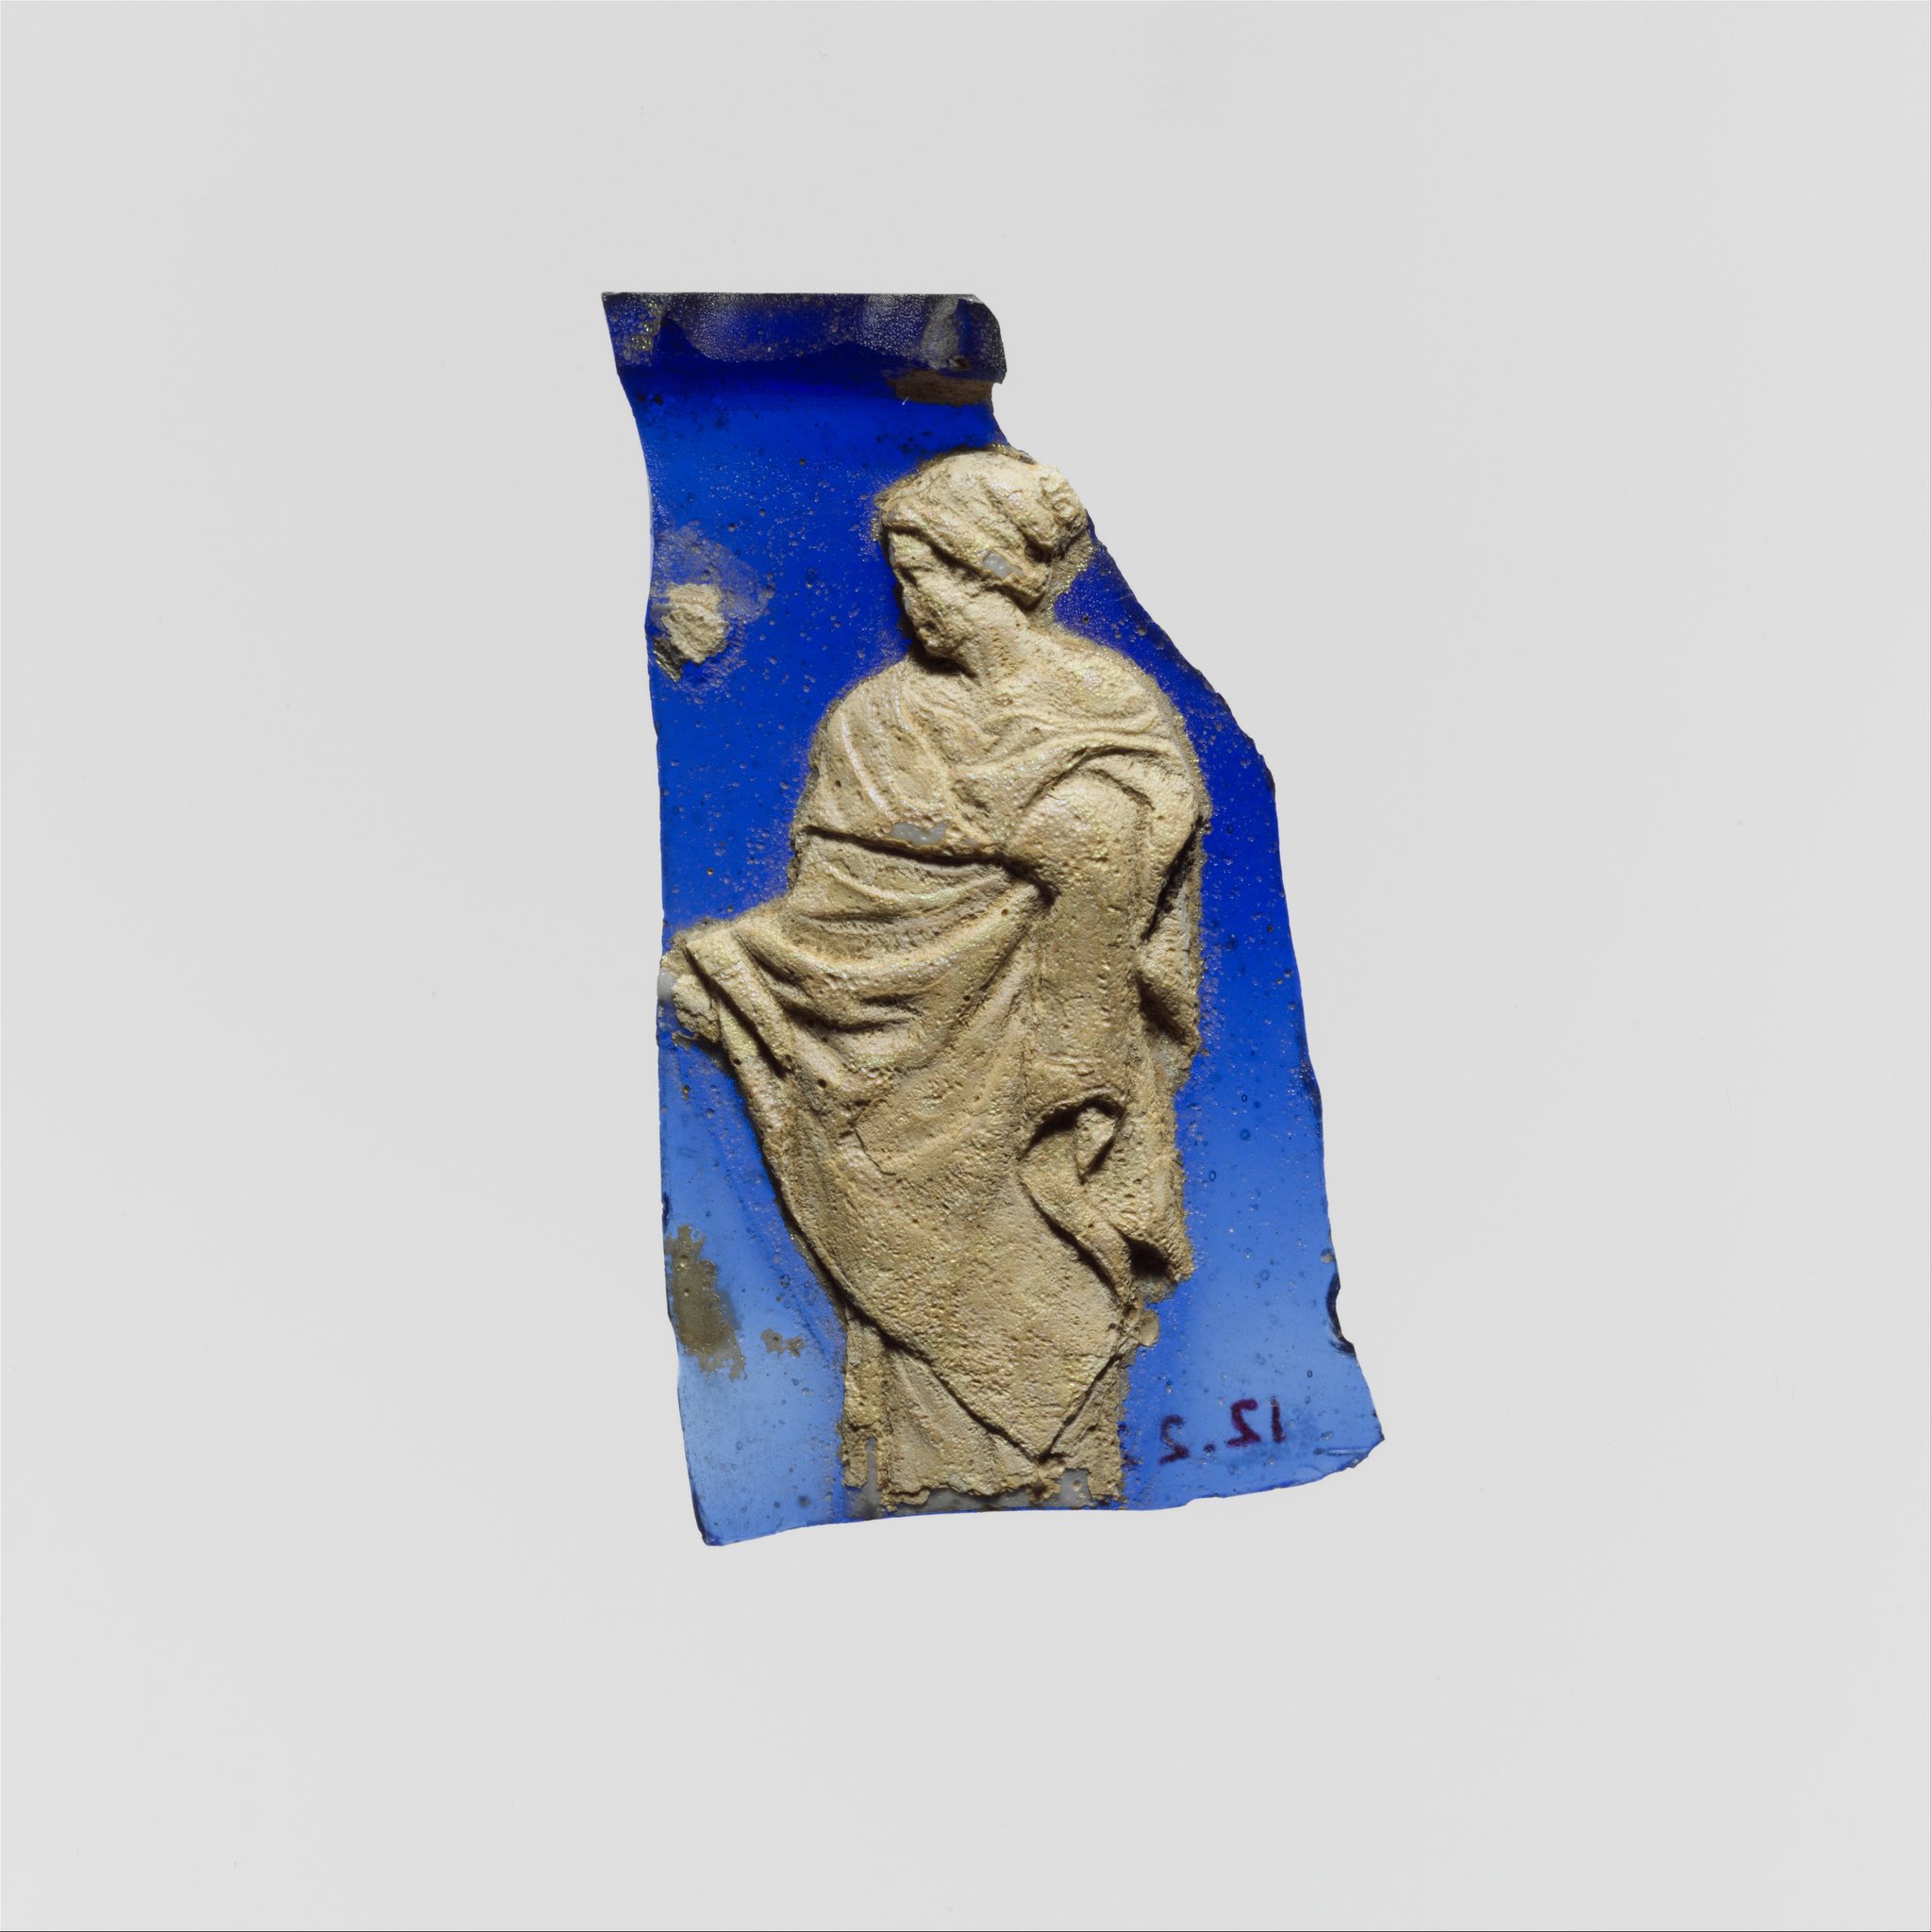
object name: cameo, cup fragment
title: Glass cameo cup (scyphus) fragment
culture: roman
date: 67-100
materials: glass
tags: women